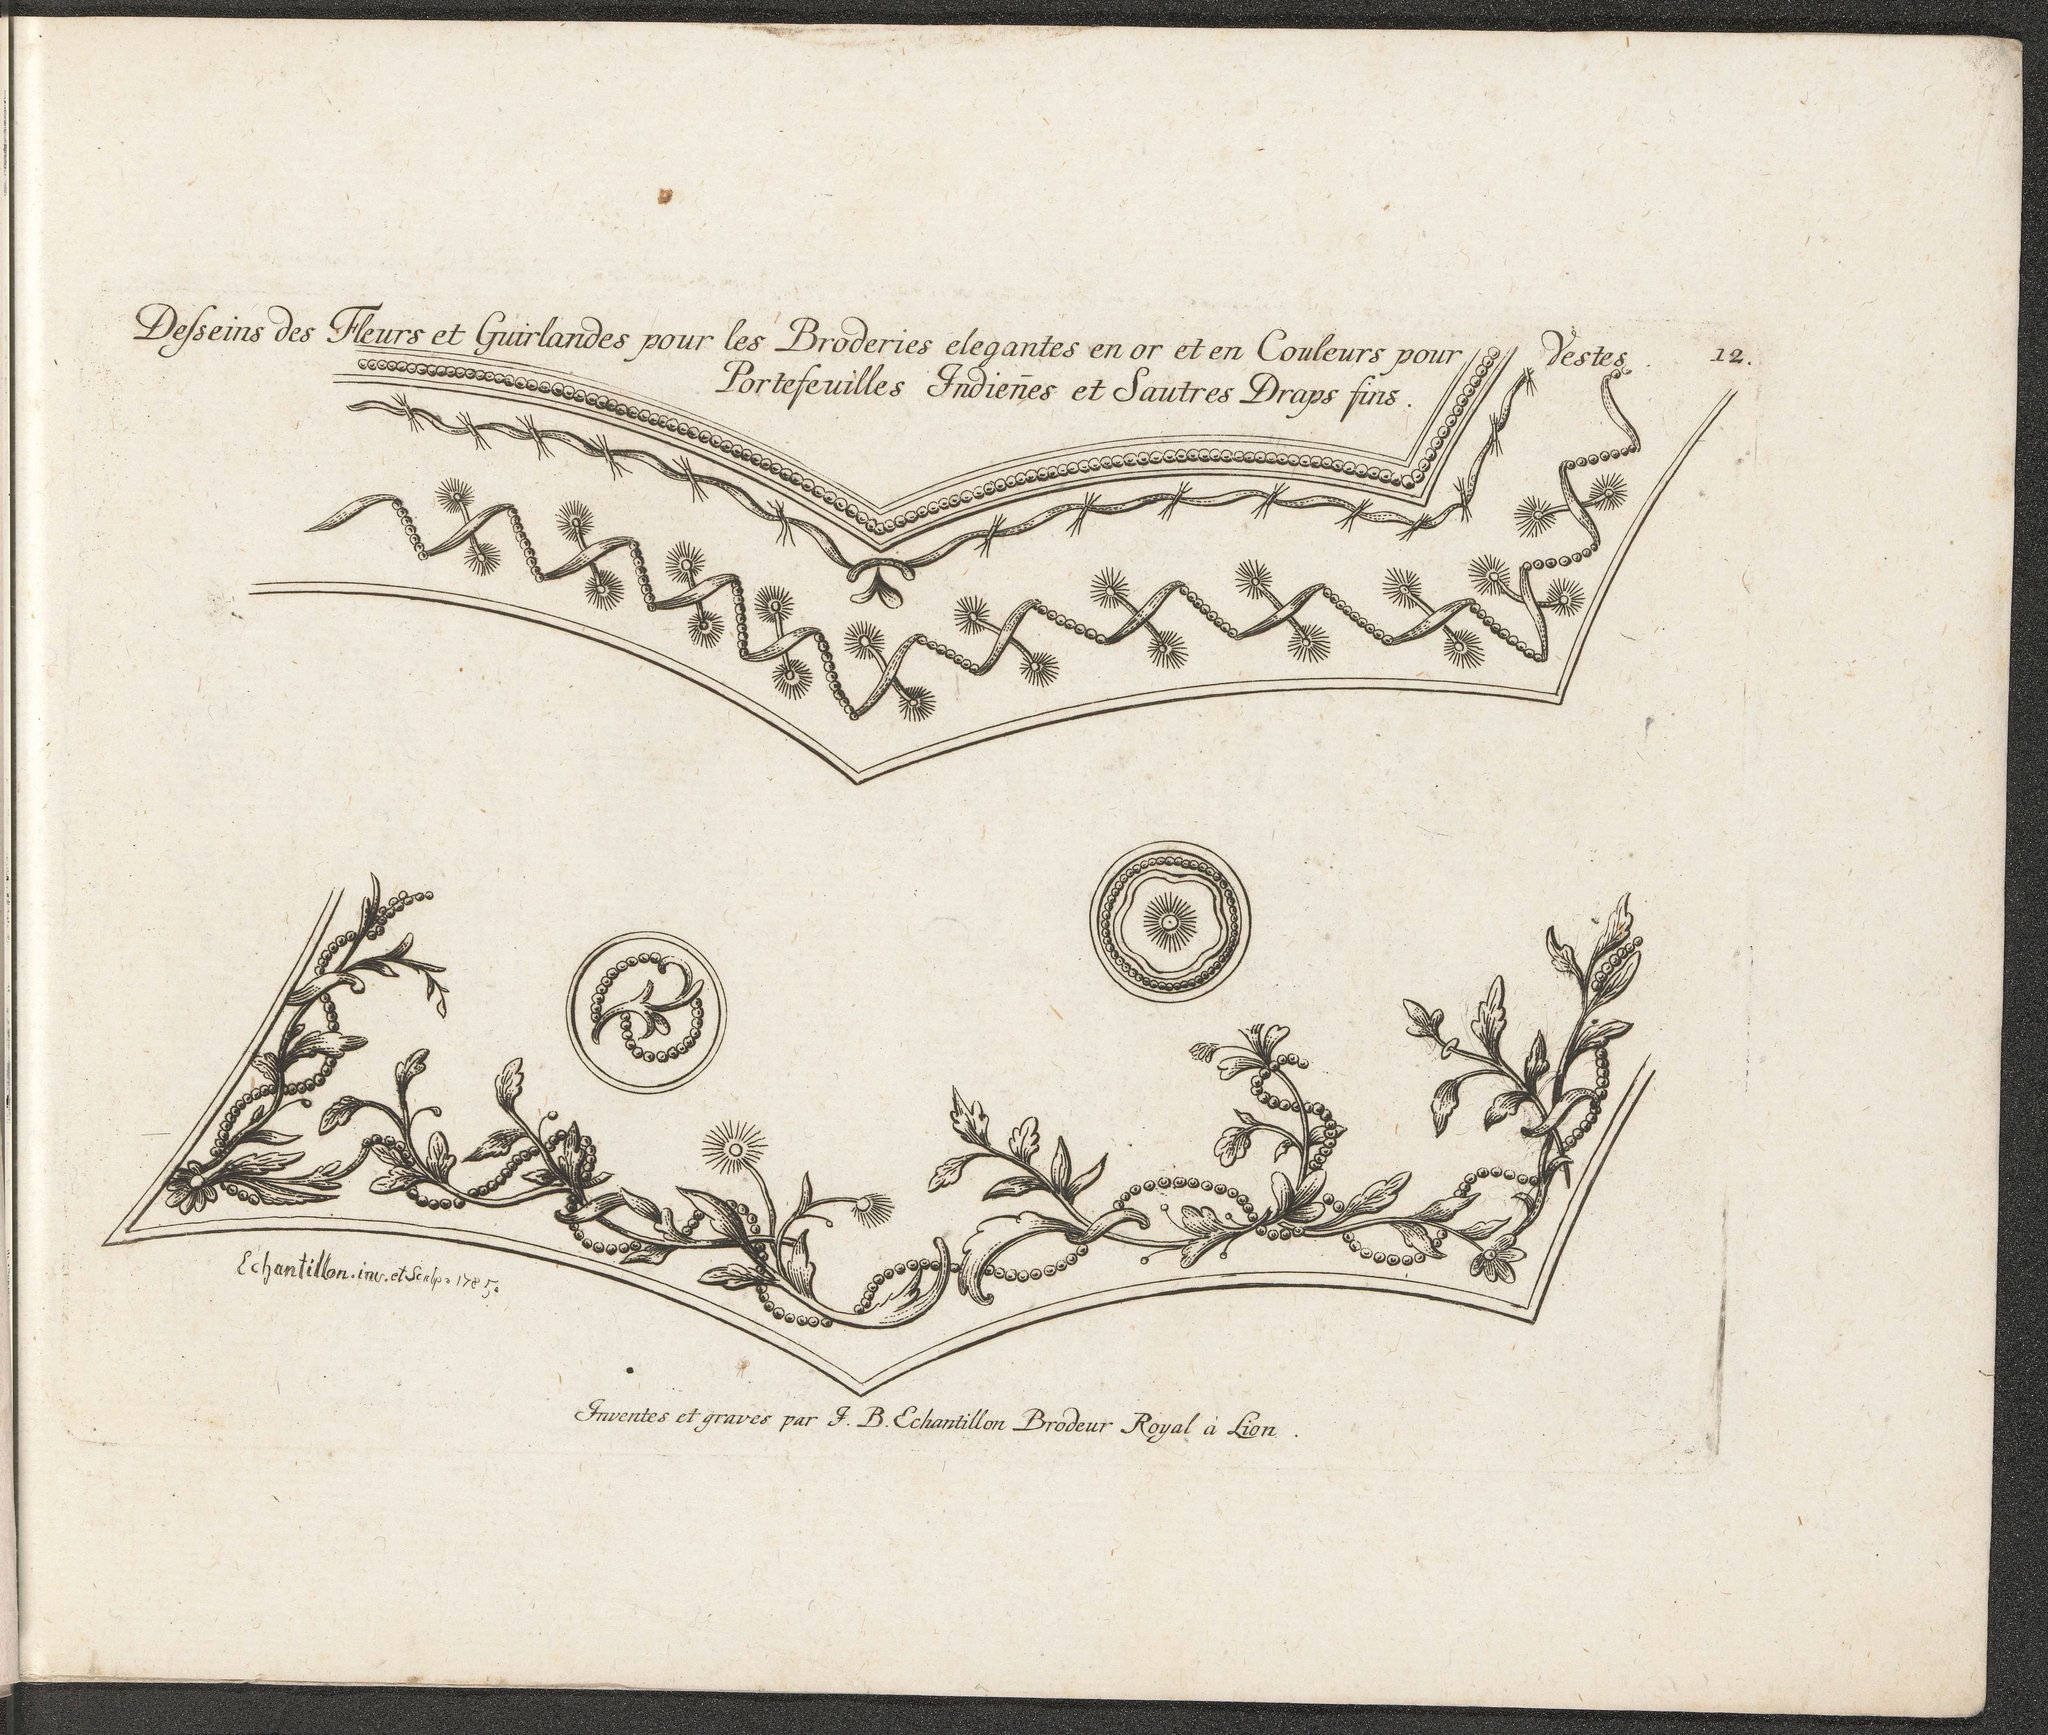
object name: print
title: Desseins des Fleurs et Guirlandes pour les Broderies elegantes en or et en Couleurs (...)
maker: jean baptiste echantillon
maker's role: print maker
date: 1785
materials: paper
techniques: etching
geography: lyon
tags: embroidery (ornamentation)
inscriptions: collector's mark: Lugt 2228, collector's mark: Lugt 2760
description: Prenten RP-P-1965-939 t/m 46 zijn aan elkaar gebonden.